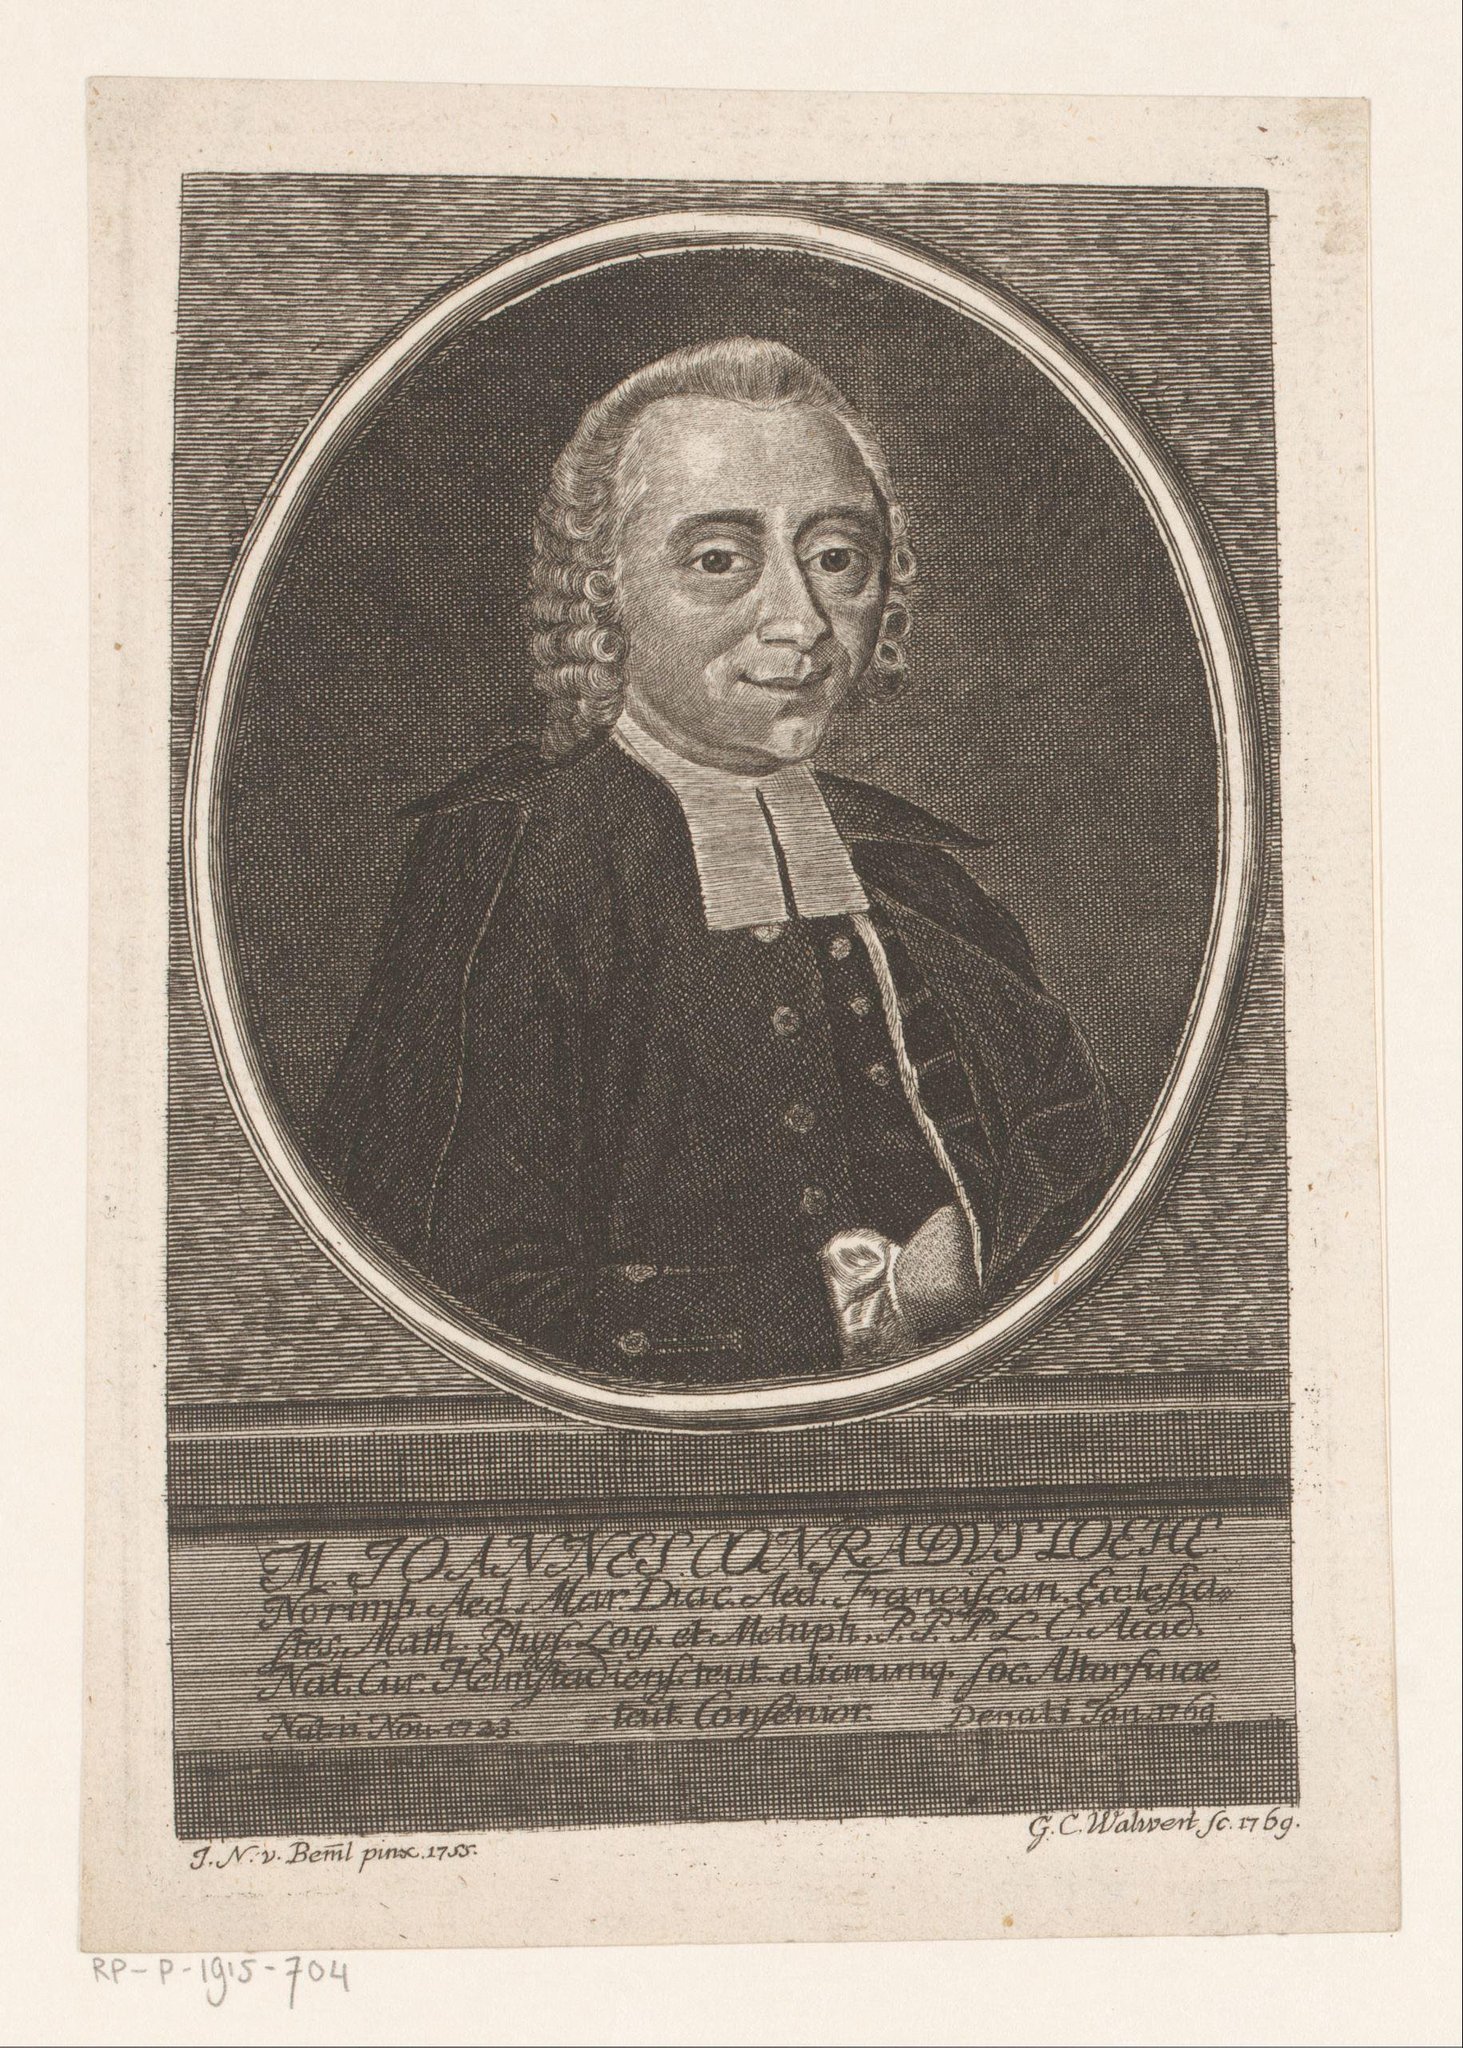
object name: print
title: Portret van Johann Conrad Löhe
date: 1769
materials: paper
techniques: engraving, etching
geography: germany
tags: historical persons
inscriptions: collector's mark: Lugt 2228